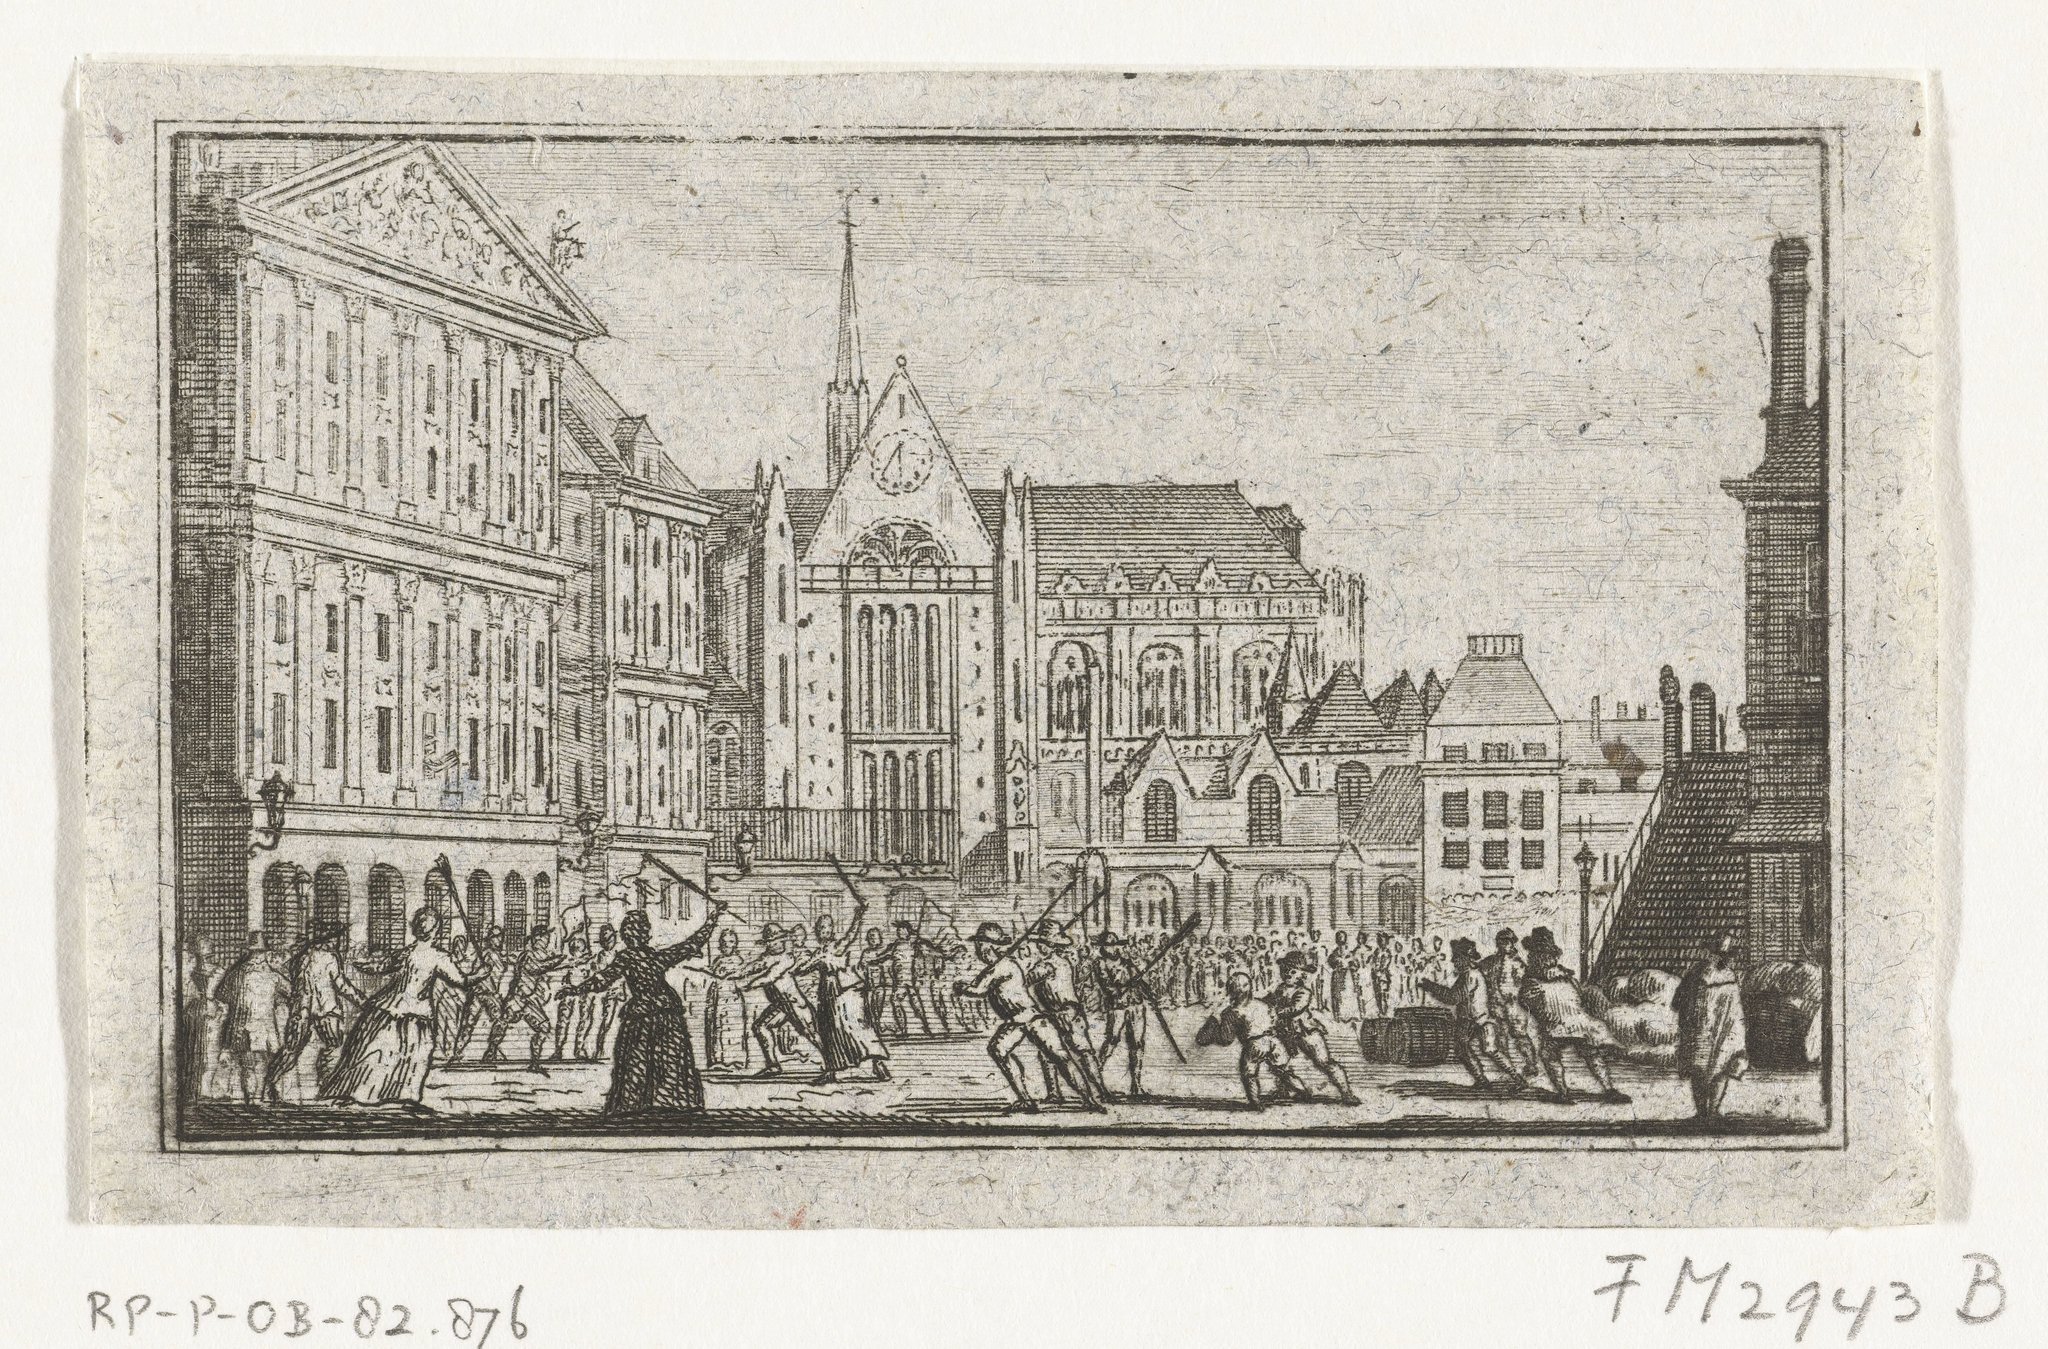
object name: print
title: Oproerkraaiers op de Dam tijdens het Aansprekersoproer, 1696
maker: Anonymous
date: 1696-1699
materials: paper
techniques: etching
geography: northern netherlands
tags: political demonstration, street-fights, riots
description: Menigte woedende burgers gewapend met stokken en bezems voor het Stadhuis op de Dam tijdens het Aansprekersoproer, 31 januari-1 februari 1696.